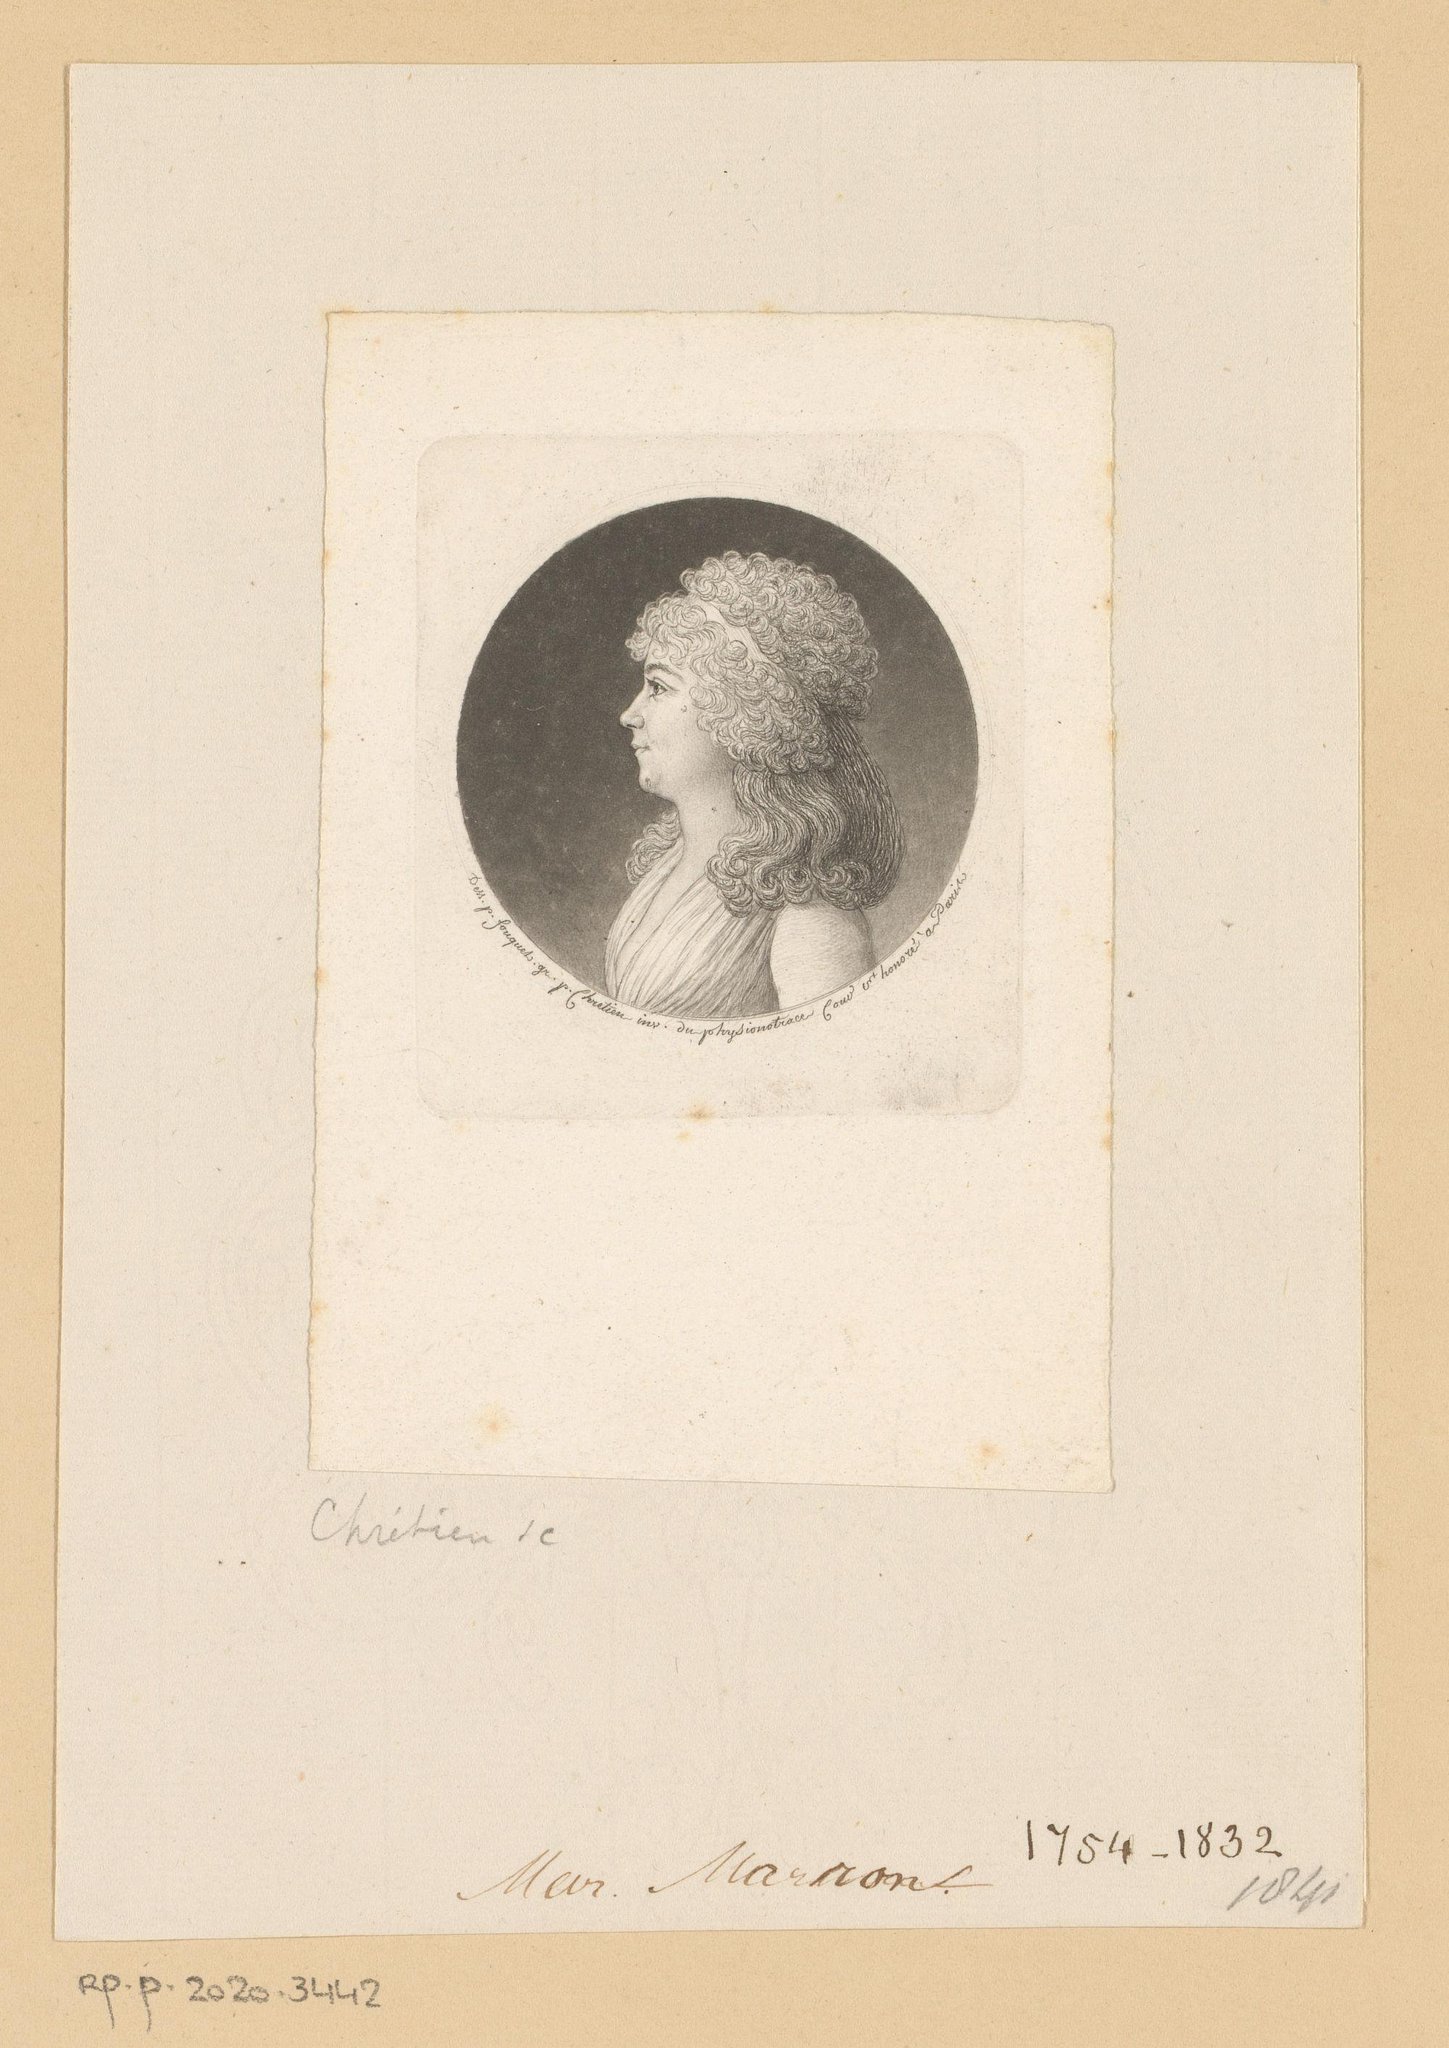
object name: print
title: Portret van een onbekende vrouw genaamd Marron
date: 1785-1811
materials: paper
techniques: aquatint, etching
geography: paris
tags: silhouette-apparatus, 'physionotrace', anonymous historical person portrayed alone - bb - woman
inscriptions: collector's mark: Lugt 2227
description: Physionotrace portret. Marron is de achternaam die deze vrouw na haar huwelijk aannam. Ze werd geboren als Mollerus.